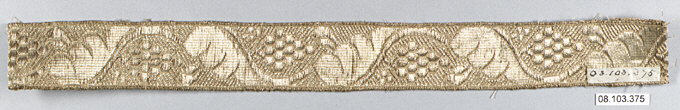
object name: galloon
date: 1601-1800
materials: metal thread